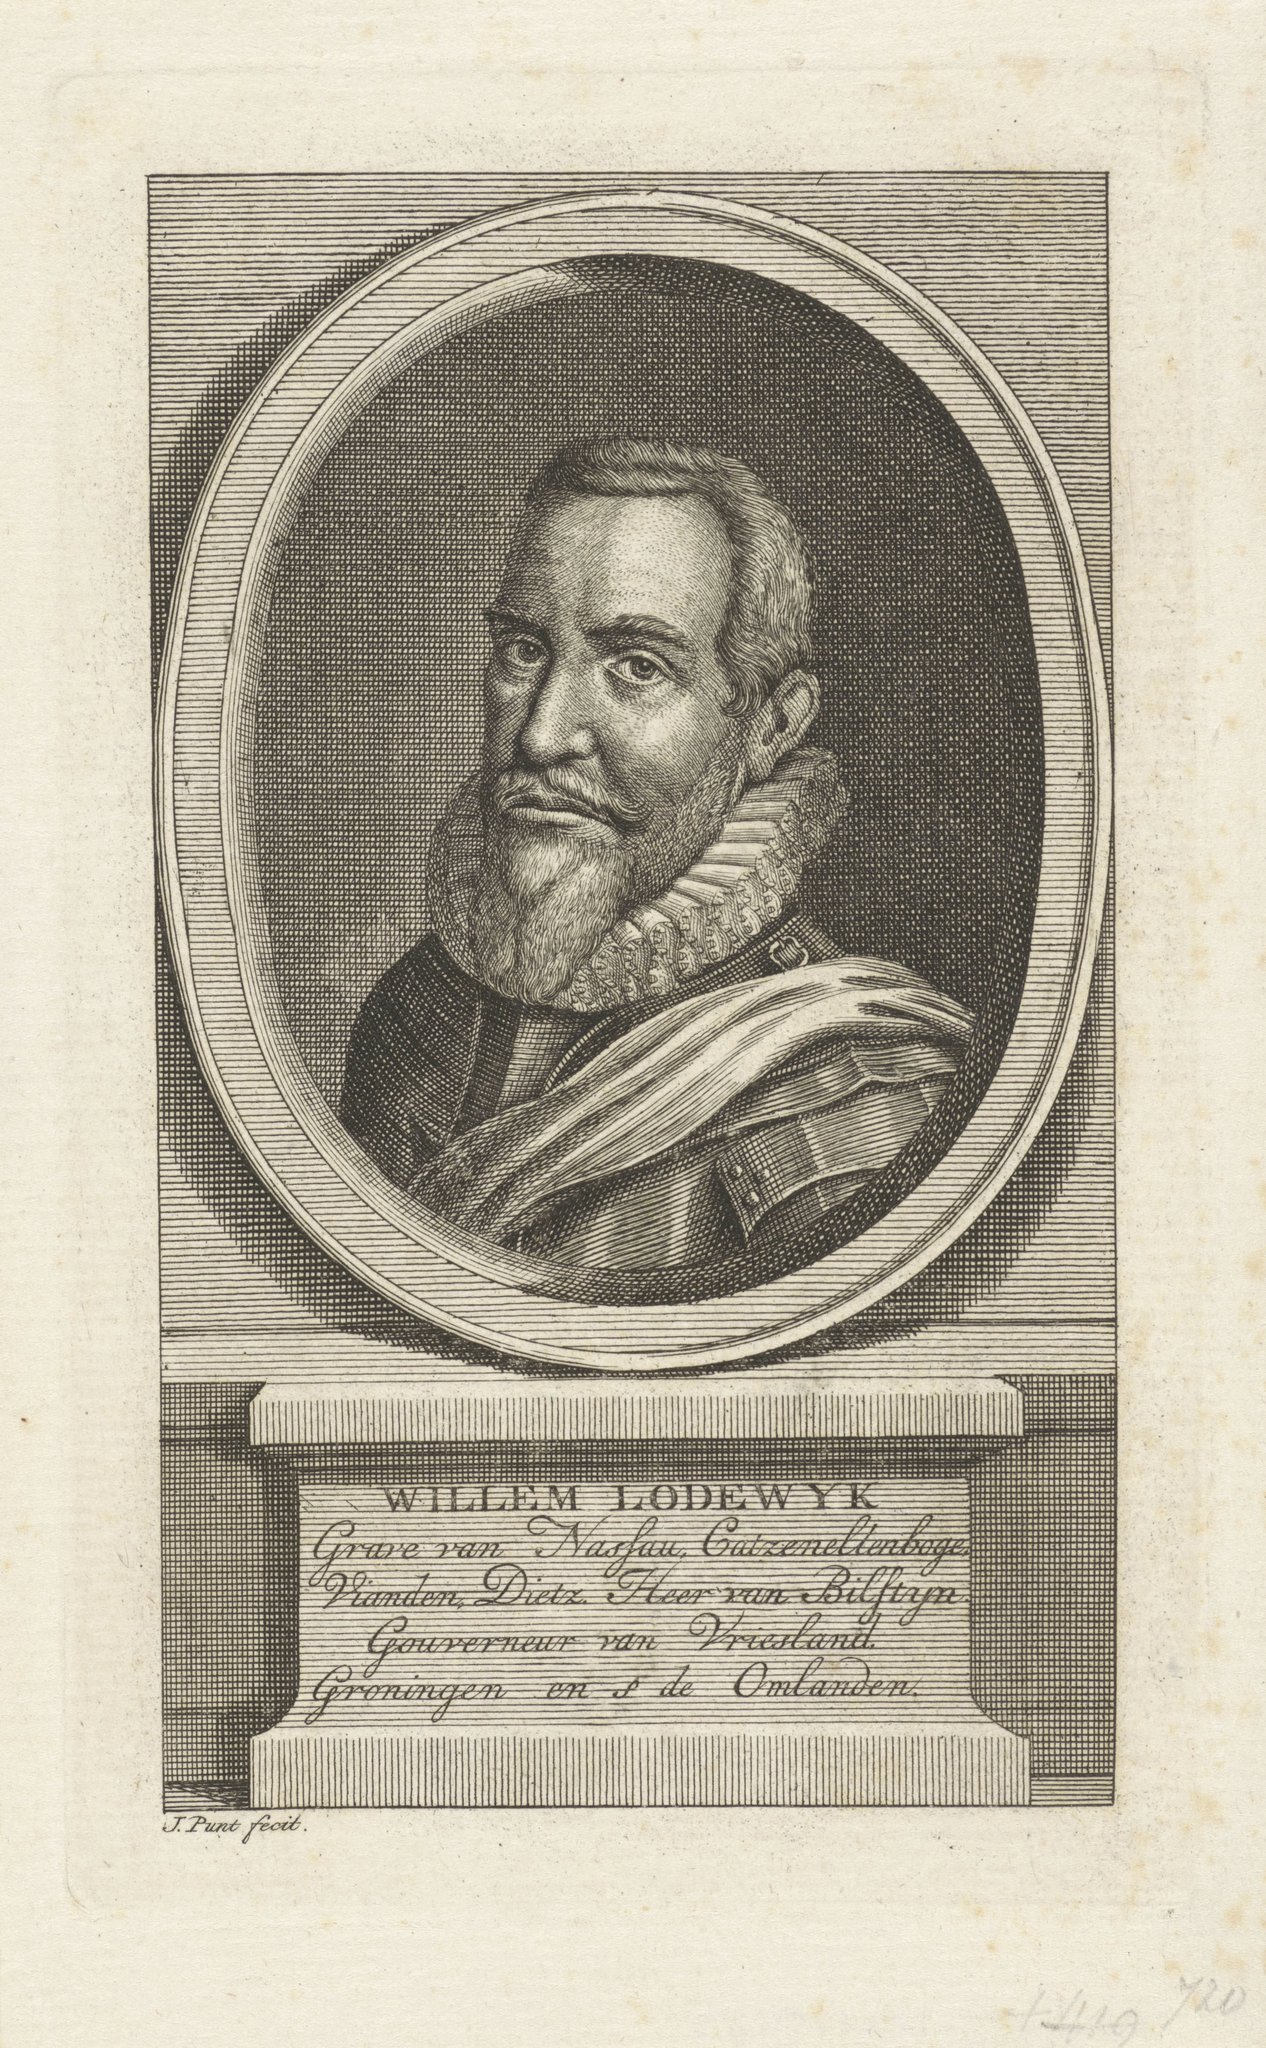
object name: print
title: Portret van Willem Lodewijk, graaf van Nassau-Dillenburg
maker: jan punt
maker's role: draughtsman, print maker, publisher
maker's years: 1711-1779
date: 1731-1779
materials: paper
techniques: engraving, etching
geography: northern netherlands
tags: willem lodewijk graaf van nassau-dillenburg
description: De hier vermelde titel verwijst naar de hoogst verkregen titel van de geportretteerde, niet per se naar de titel die de geportretteerde op deze voorstelling draagt.